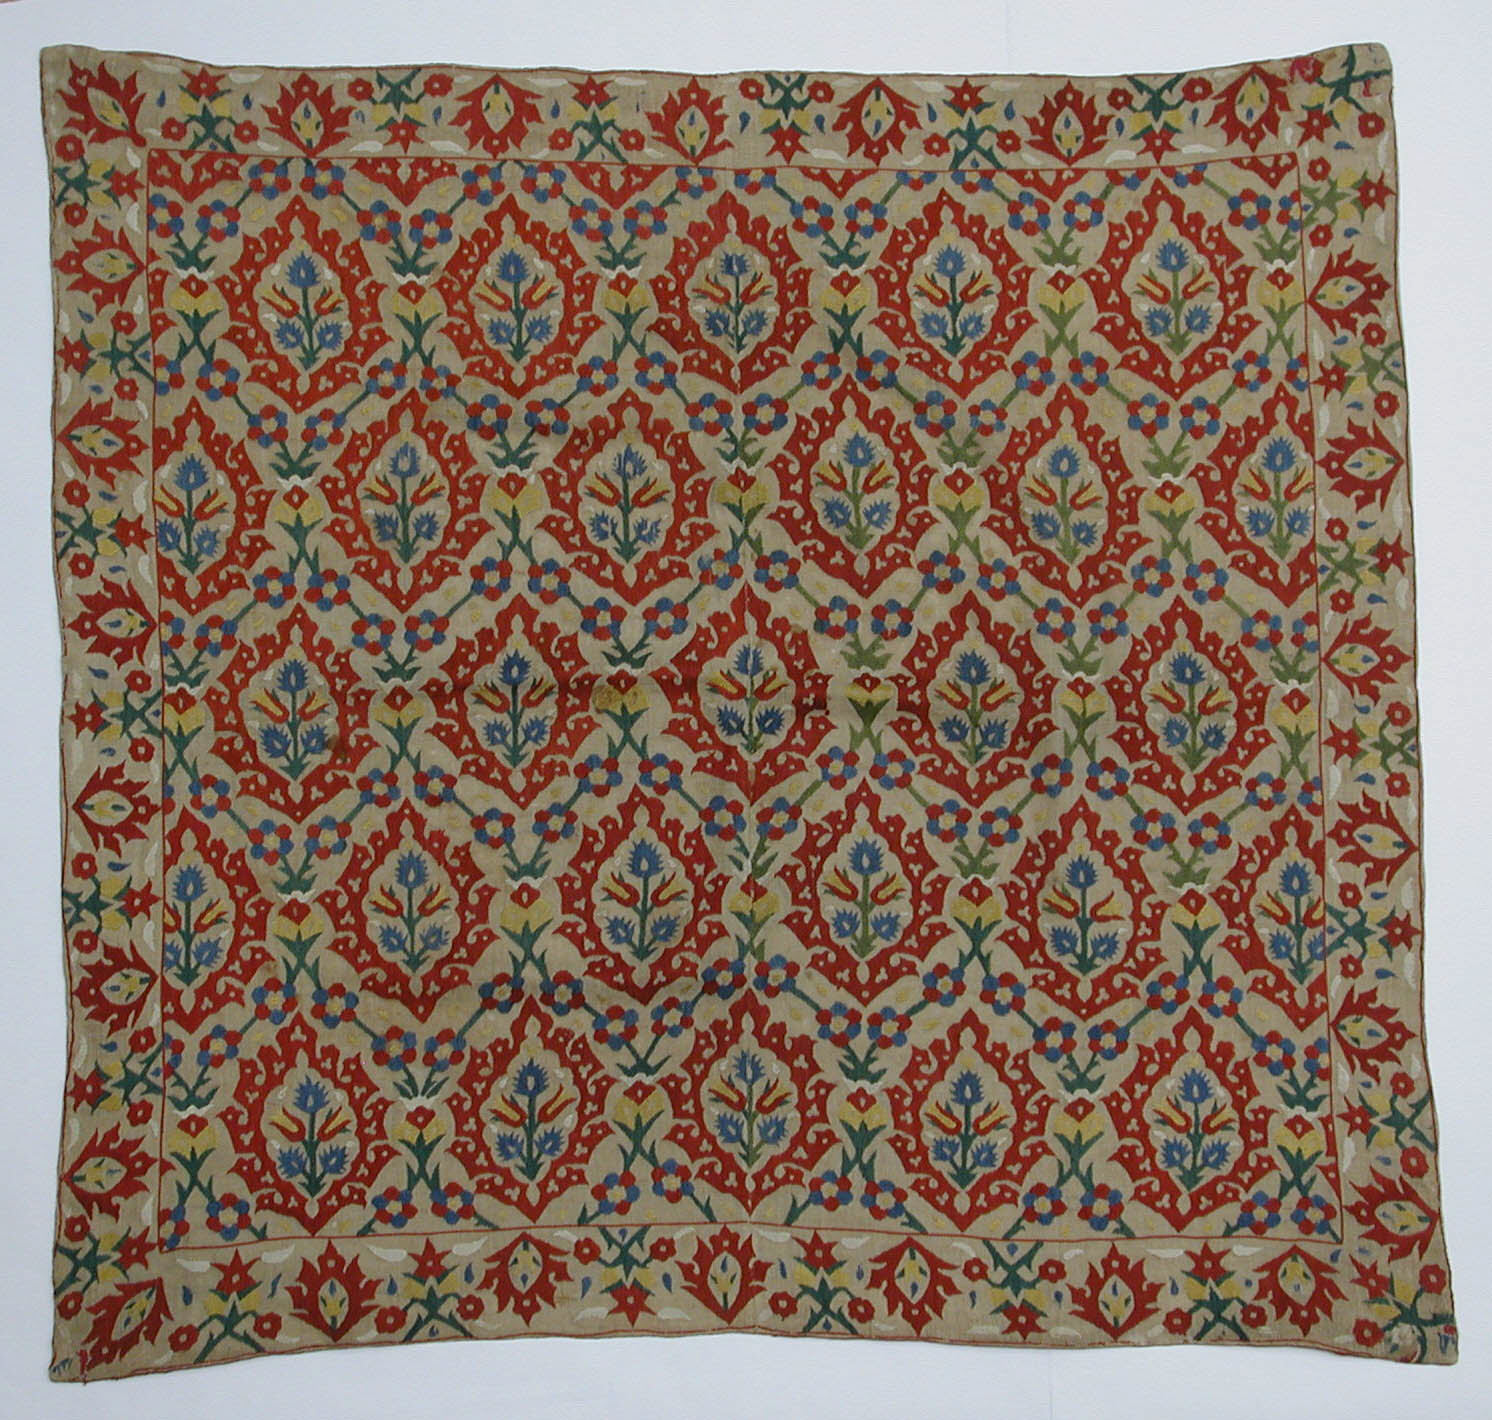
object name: cover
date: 1667-1700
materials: linen, silk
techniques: embroidery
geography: turkey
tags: flowers